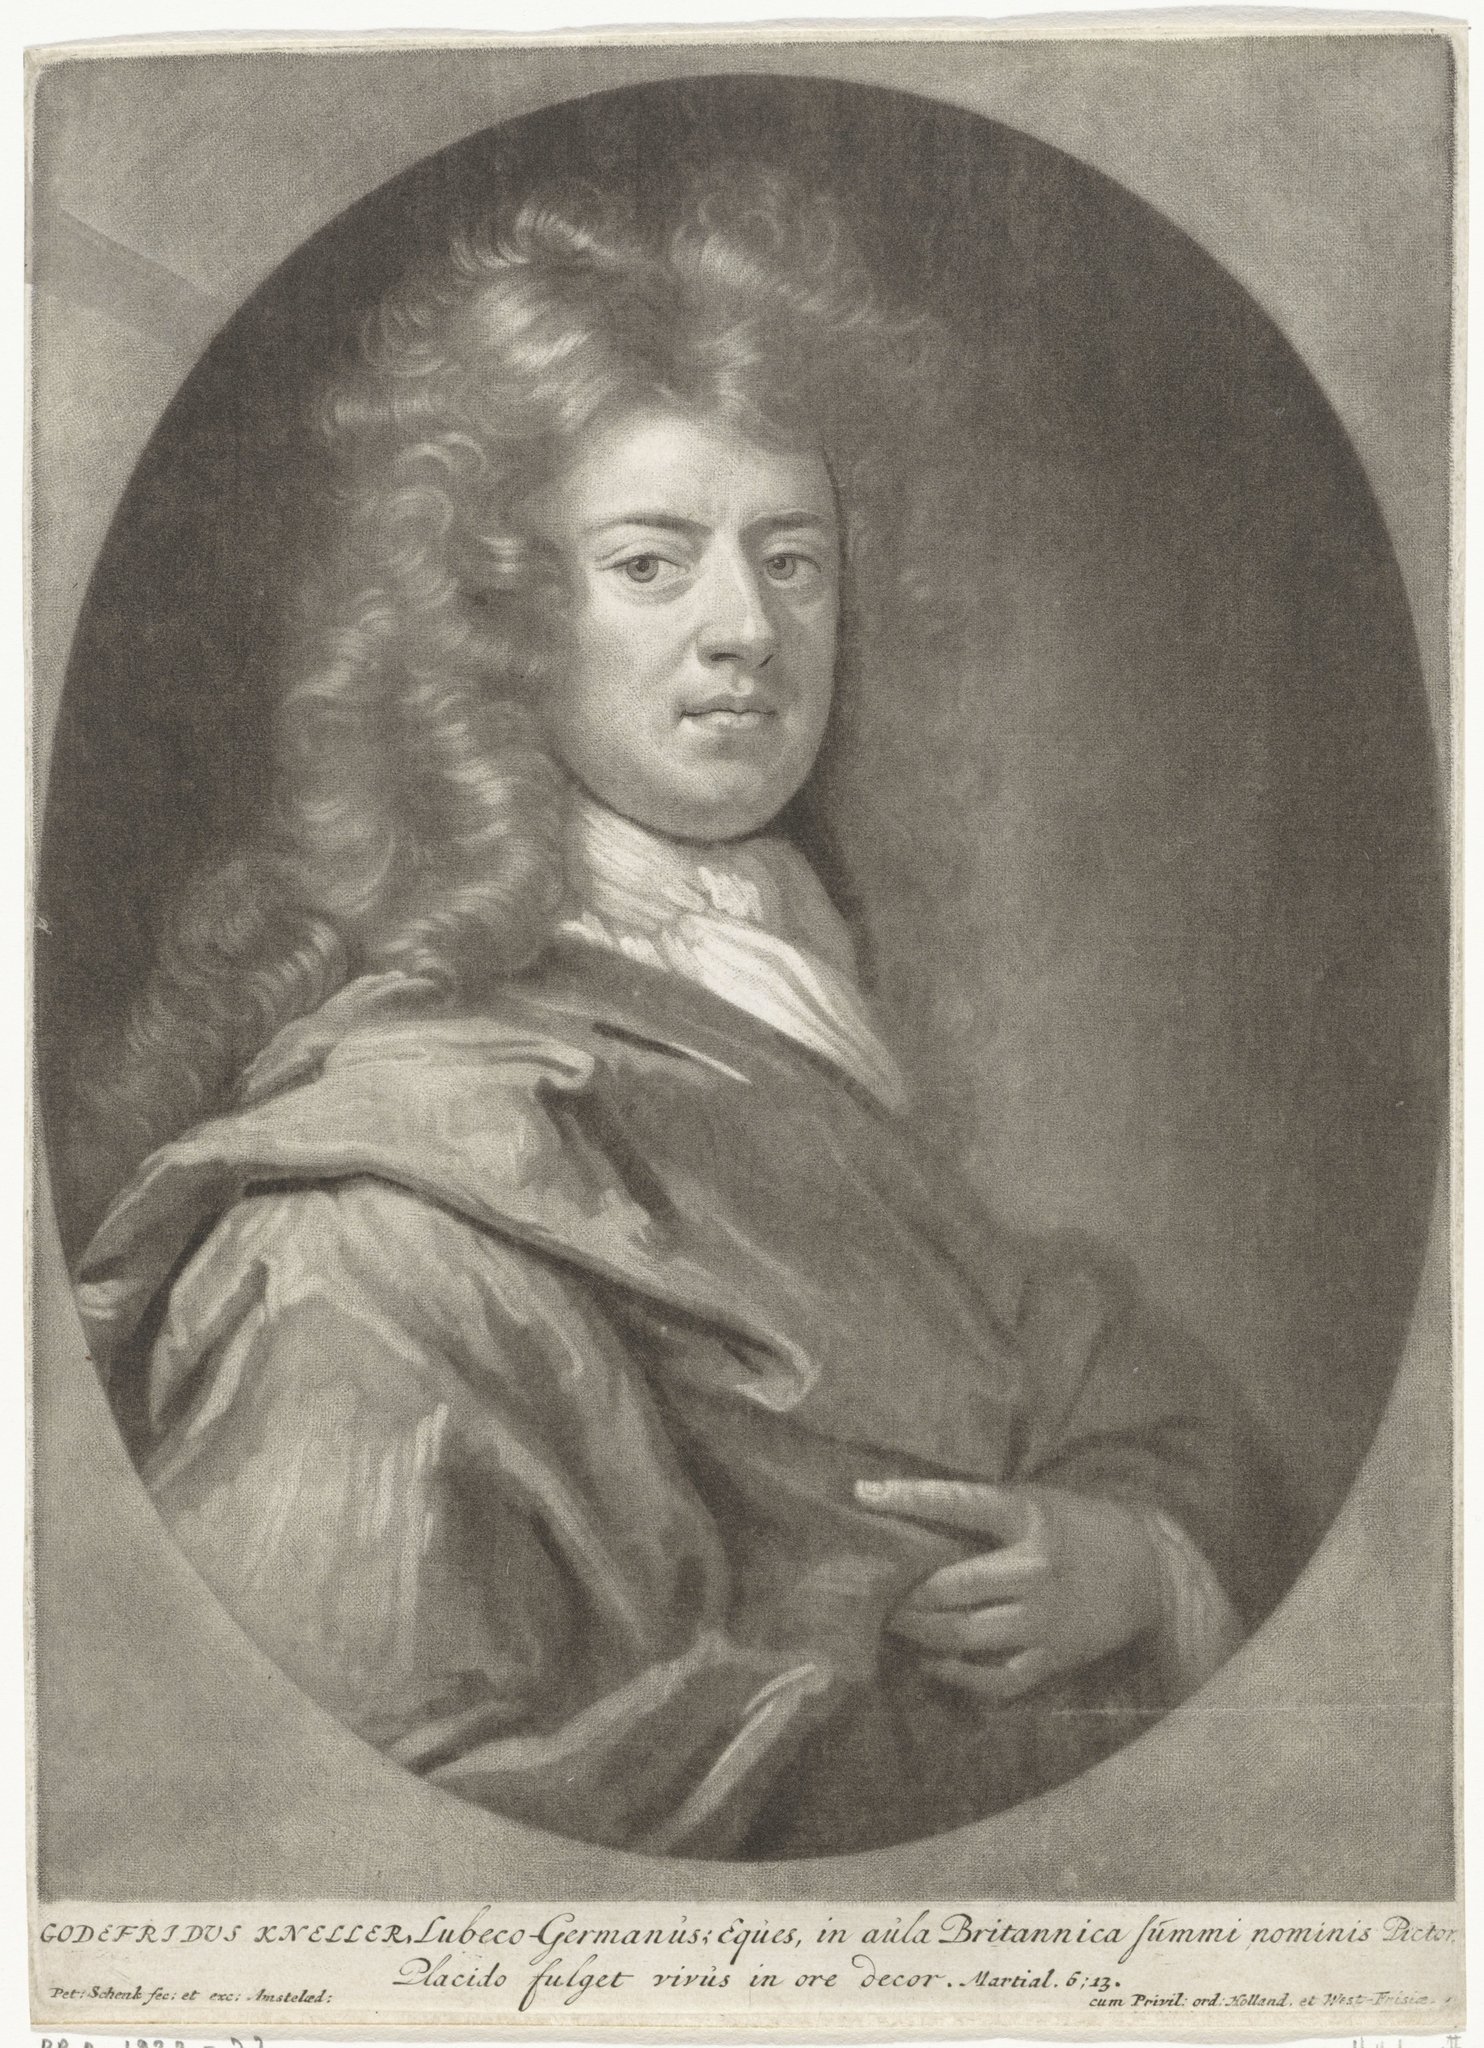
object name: print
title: Portret van de tekenaar en schilder Gottfried Kneller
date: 1670-1713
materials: paper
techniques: engraving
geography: amsterdam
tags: london, painter, gottfried kneller, portrait, self-portrait of painter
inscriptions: collector's mark: Lugt 2165